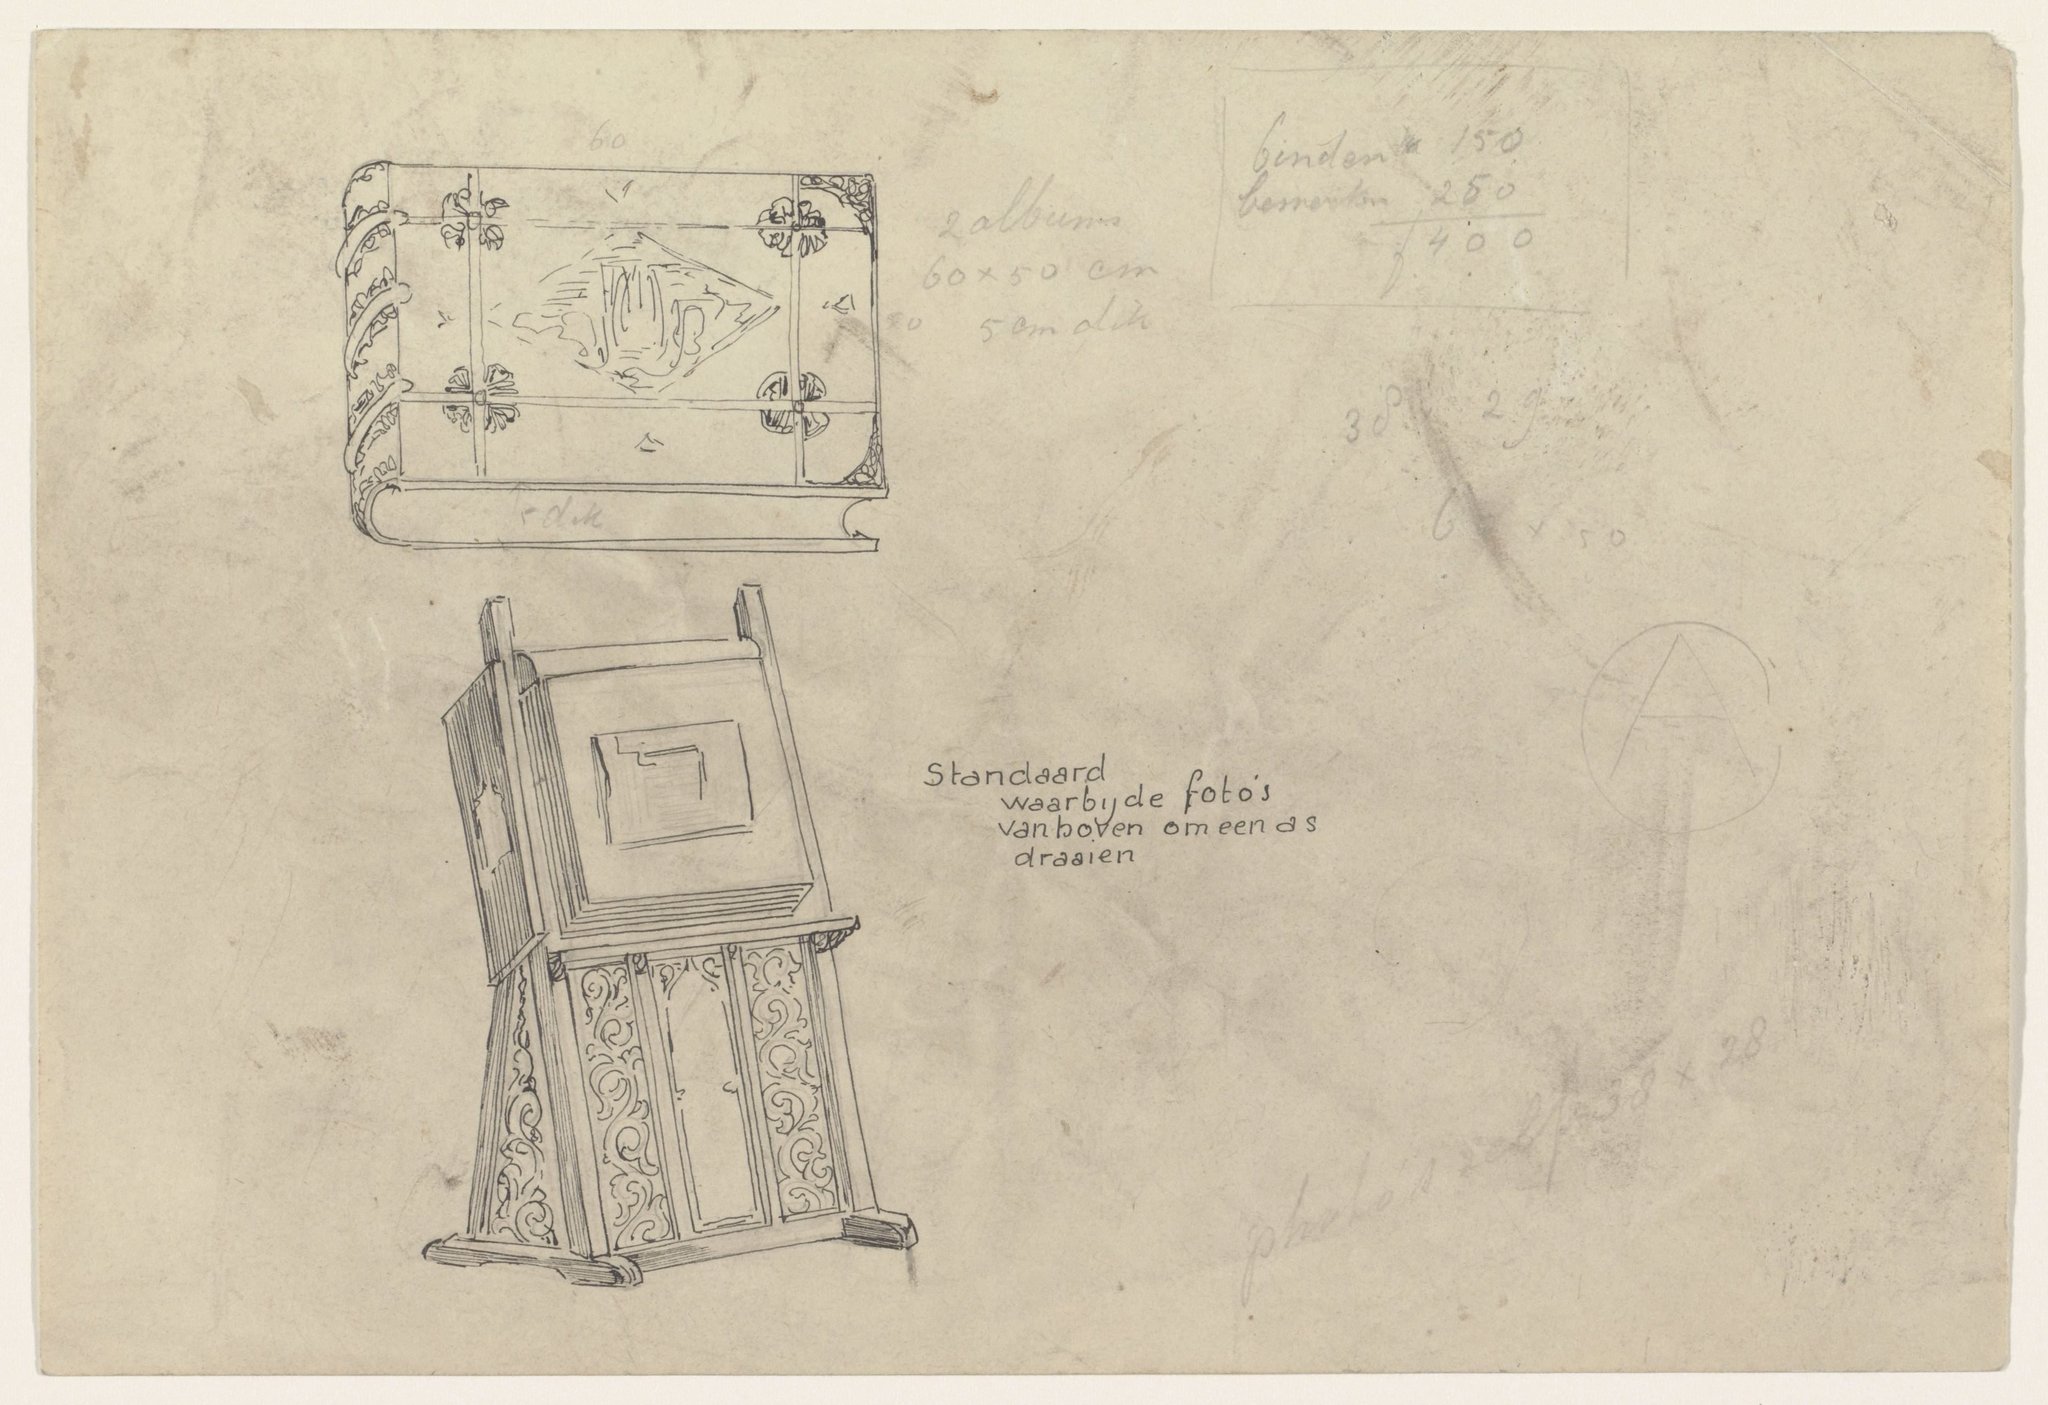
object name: design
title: Ontwerpen voor een portefeuillestandaard en een boekband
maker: carel adolph lion cachet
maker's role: draughtsman, print maker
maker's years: 1864-1945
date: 1874-1945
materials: ink, paper, pencil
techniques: pen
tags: tripod, book-cover, binding